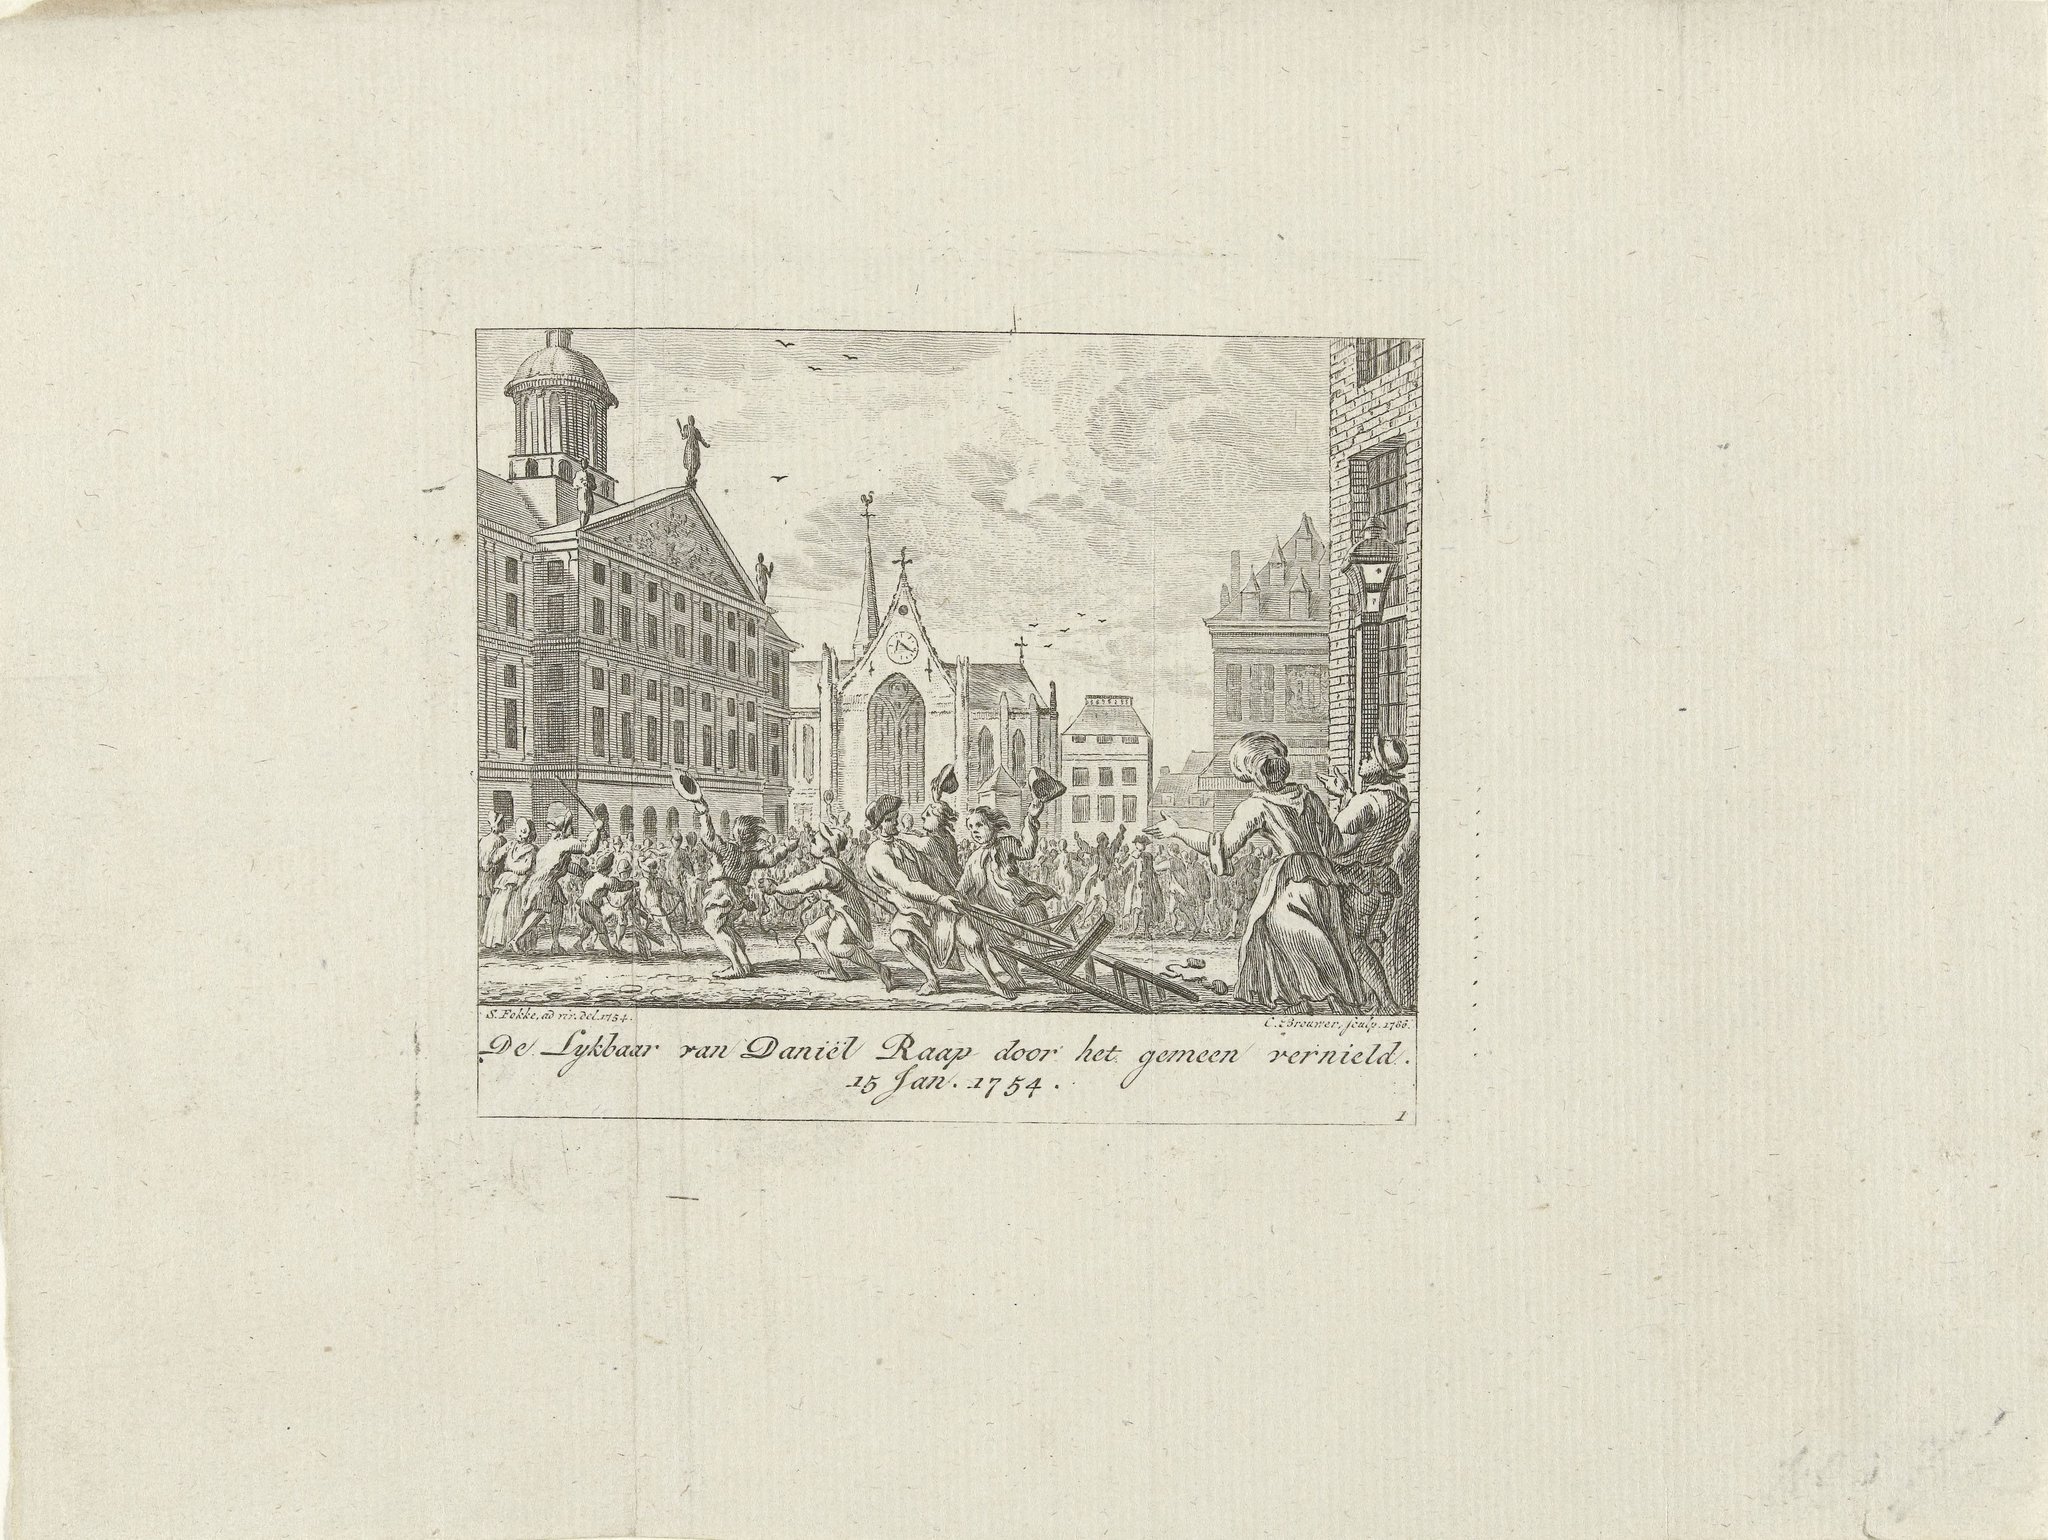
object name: print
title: De Lykbaar van Daniël Raap door het gemeen vernield. 15 Jan. 1754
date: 1786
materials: paper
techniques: engraving, etching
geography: northern netherlands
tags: funerary ceremonial, street-fights, riots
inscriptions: collector's mark: Lugt 2228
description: De vernieling van de lijkbaar van de koopman en orangist Daniël Raap tijdens zijn begrafenis op 15 januari 1754 door oproerig volk op de Dam te Amsterdam. Onderdeel van een groep van vier illustraties van de ongeregeldheden bij de begrafenis van Daniël Raap te Amsterdam. Genummerd rechtsonder: 1.